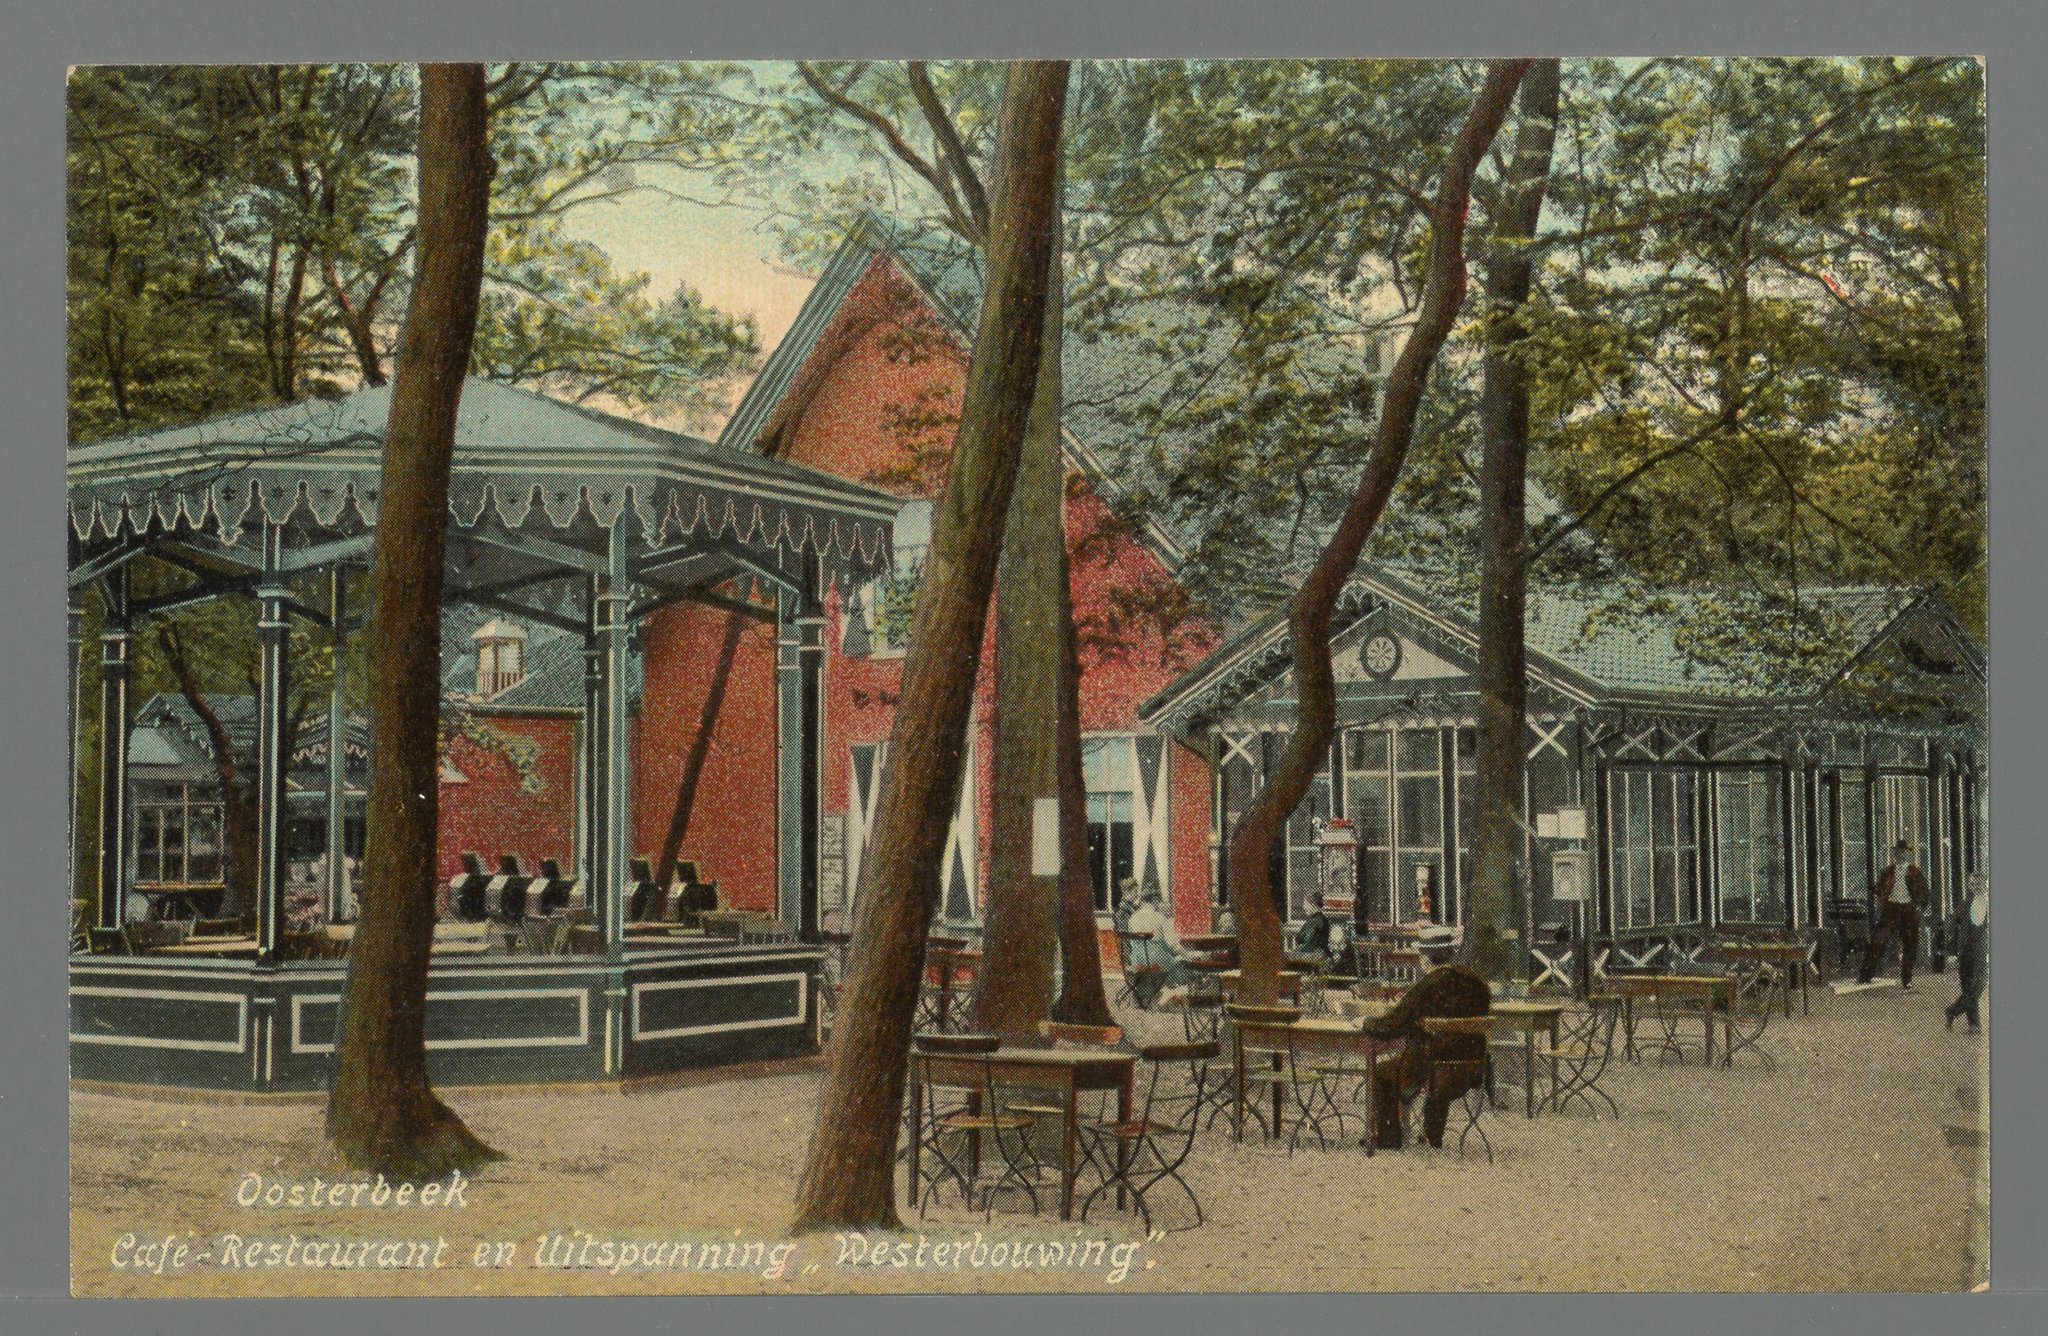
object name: ansichtkaart, prentbriefkaart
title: Oosterbeek. Café-Restaurant en Uitspanning "Westerbouwing"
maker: Anonymous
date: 1909-1918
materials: cardboard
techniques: lithograph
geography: leipzig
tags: restaurant